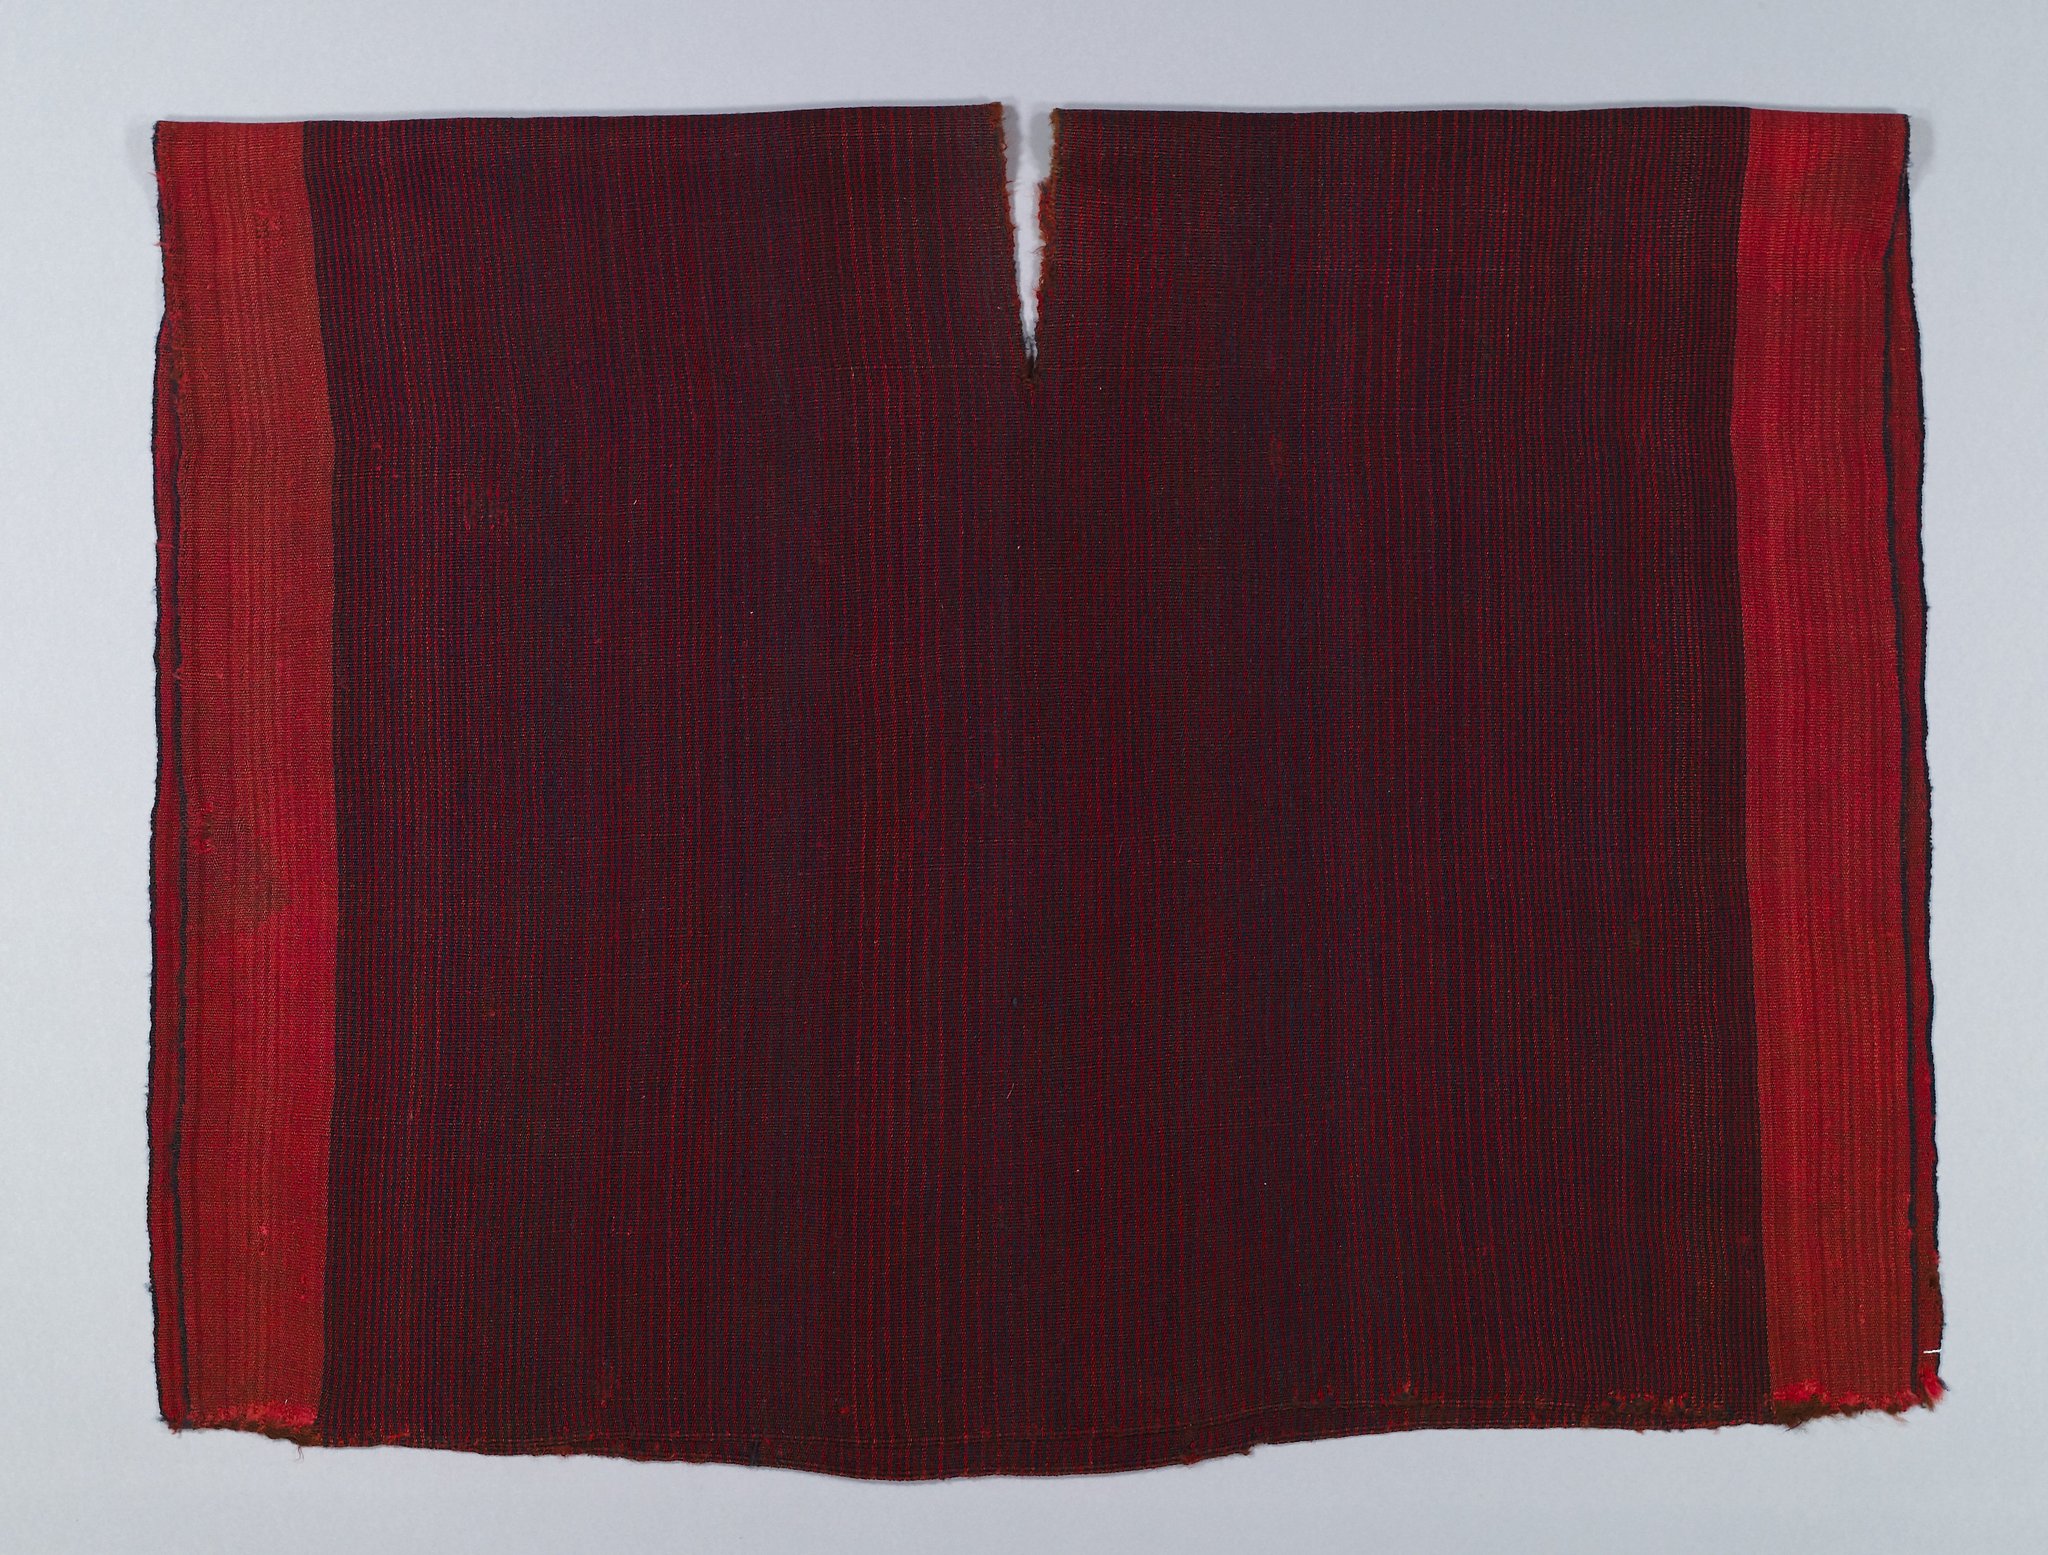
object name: tunic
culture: aymara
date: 1767-1800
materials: animal fiber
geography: bolivia